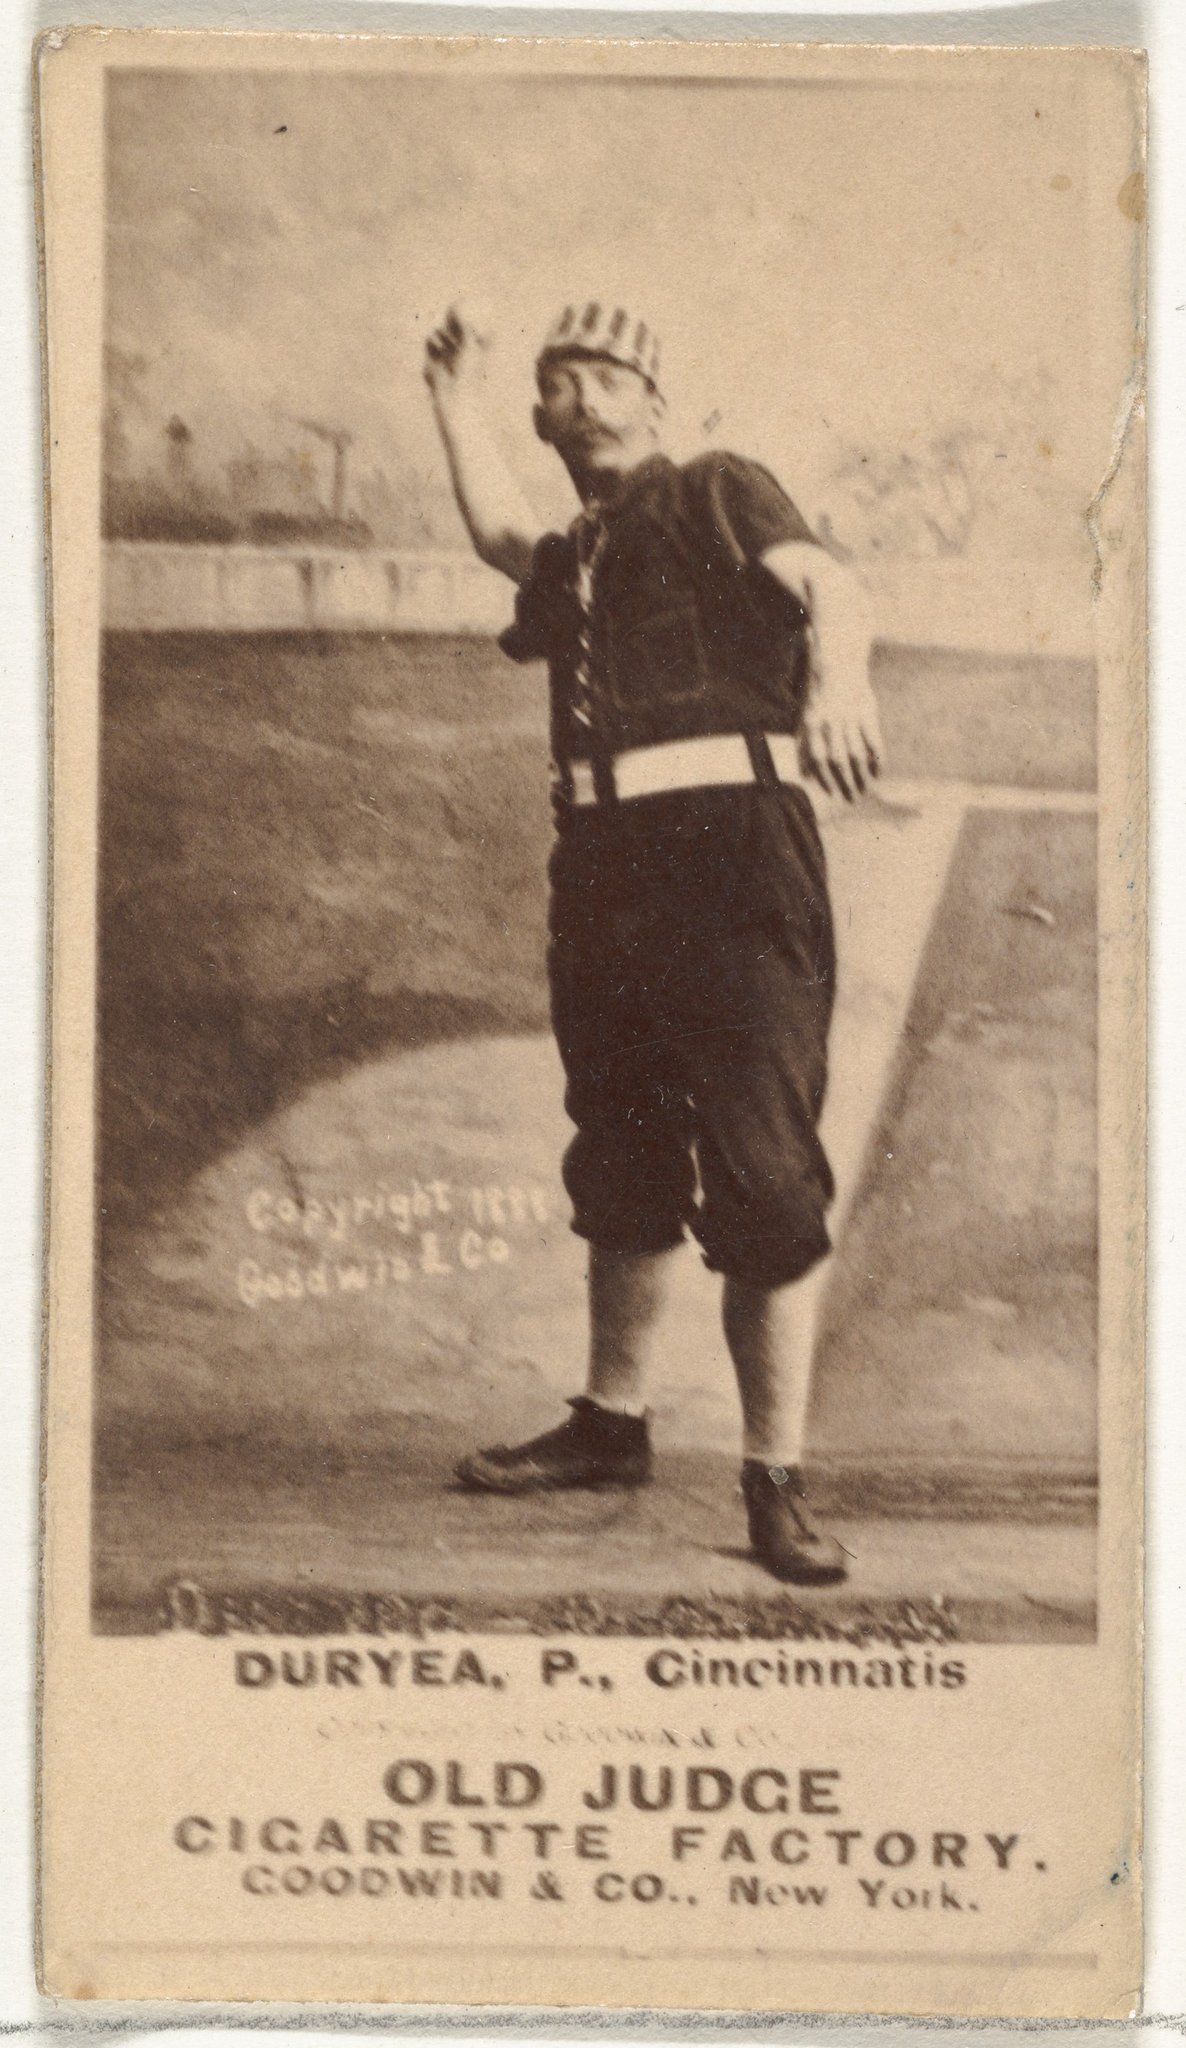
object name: baseball card, photograph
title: James Newton "Jesse" Duryea, Pitcher, Cincinnati, from the Old Judge series (N172) for Old Judge Cigarettes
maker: goodwin & company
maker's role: publisher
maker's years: 1850-1950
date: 1888-1889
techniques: albumen silver print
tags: men,portraits,baseball,athletes